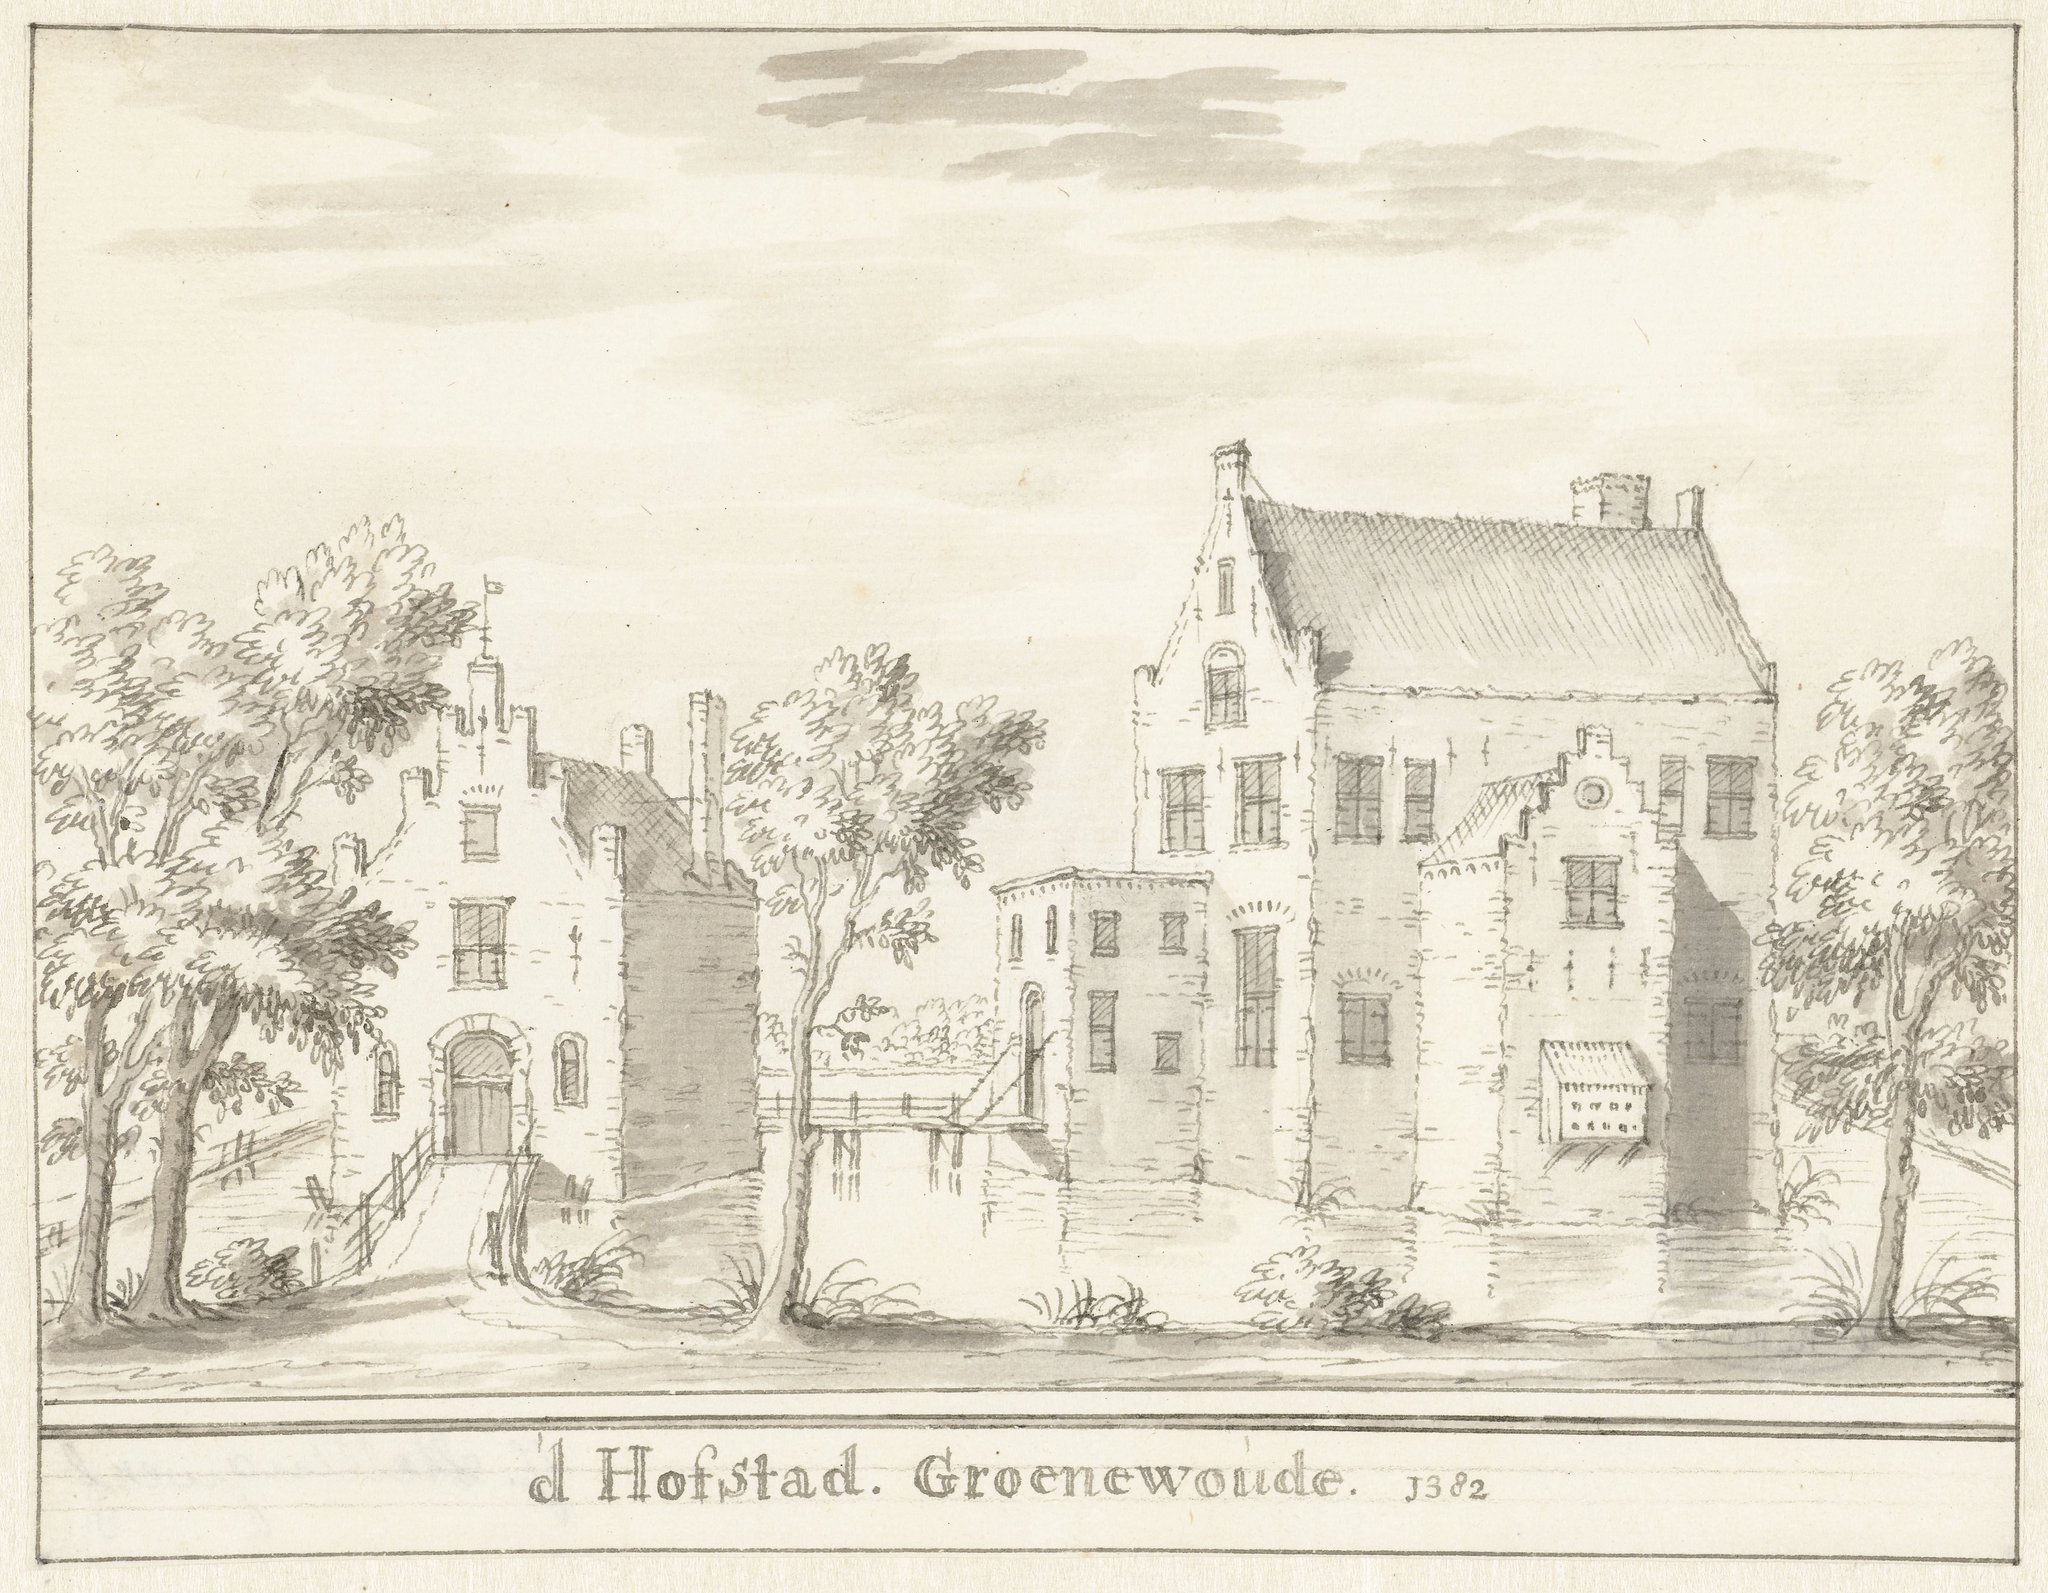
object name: drawing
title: 'd Hofstad Groenewoude 1382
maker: jacobus stellingwerff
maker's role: draughtsman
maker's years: 1660-1736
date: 1670-1736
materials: ink, paper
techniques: brush, pen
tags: castle, woudenberg